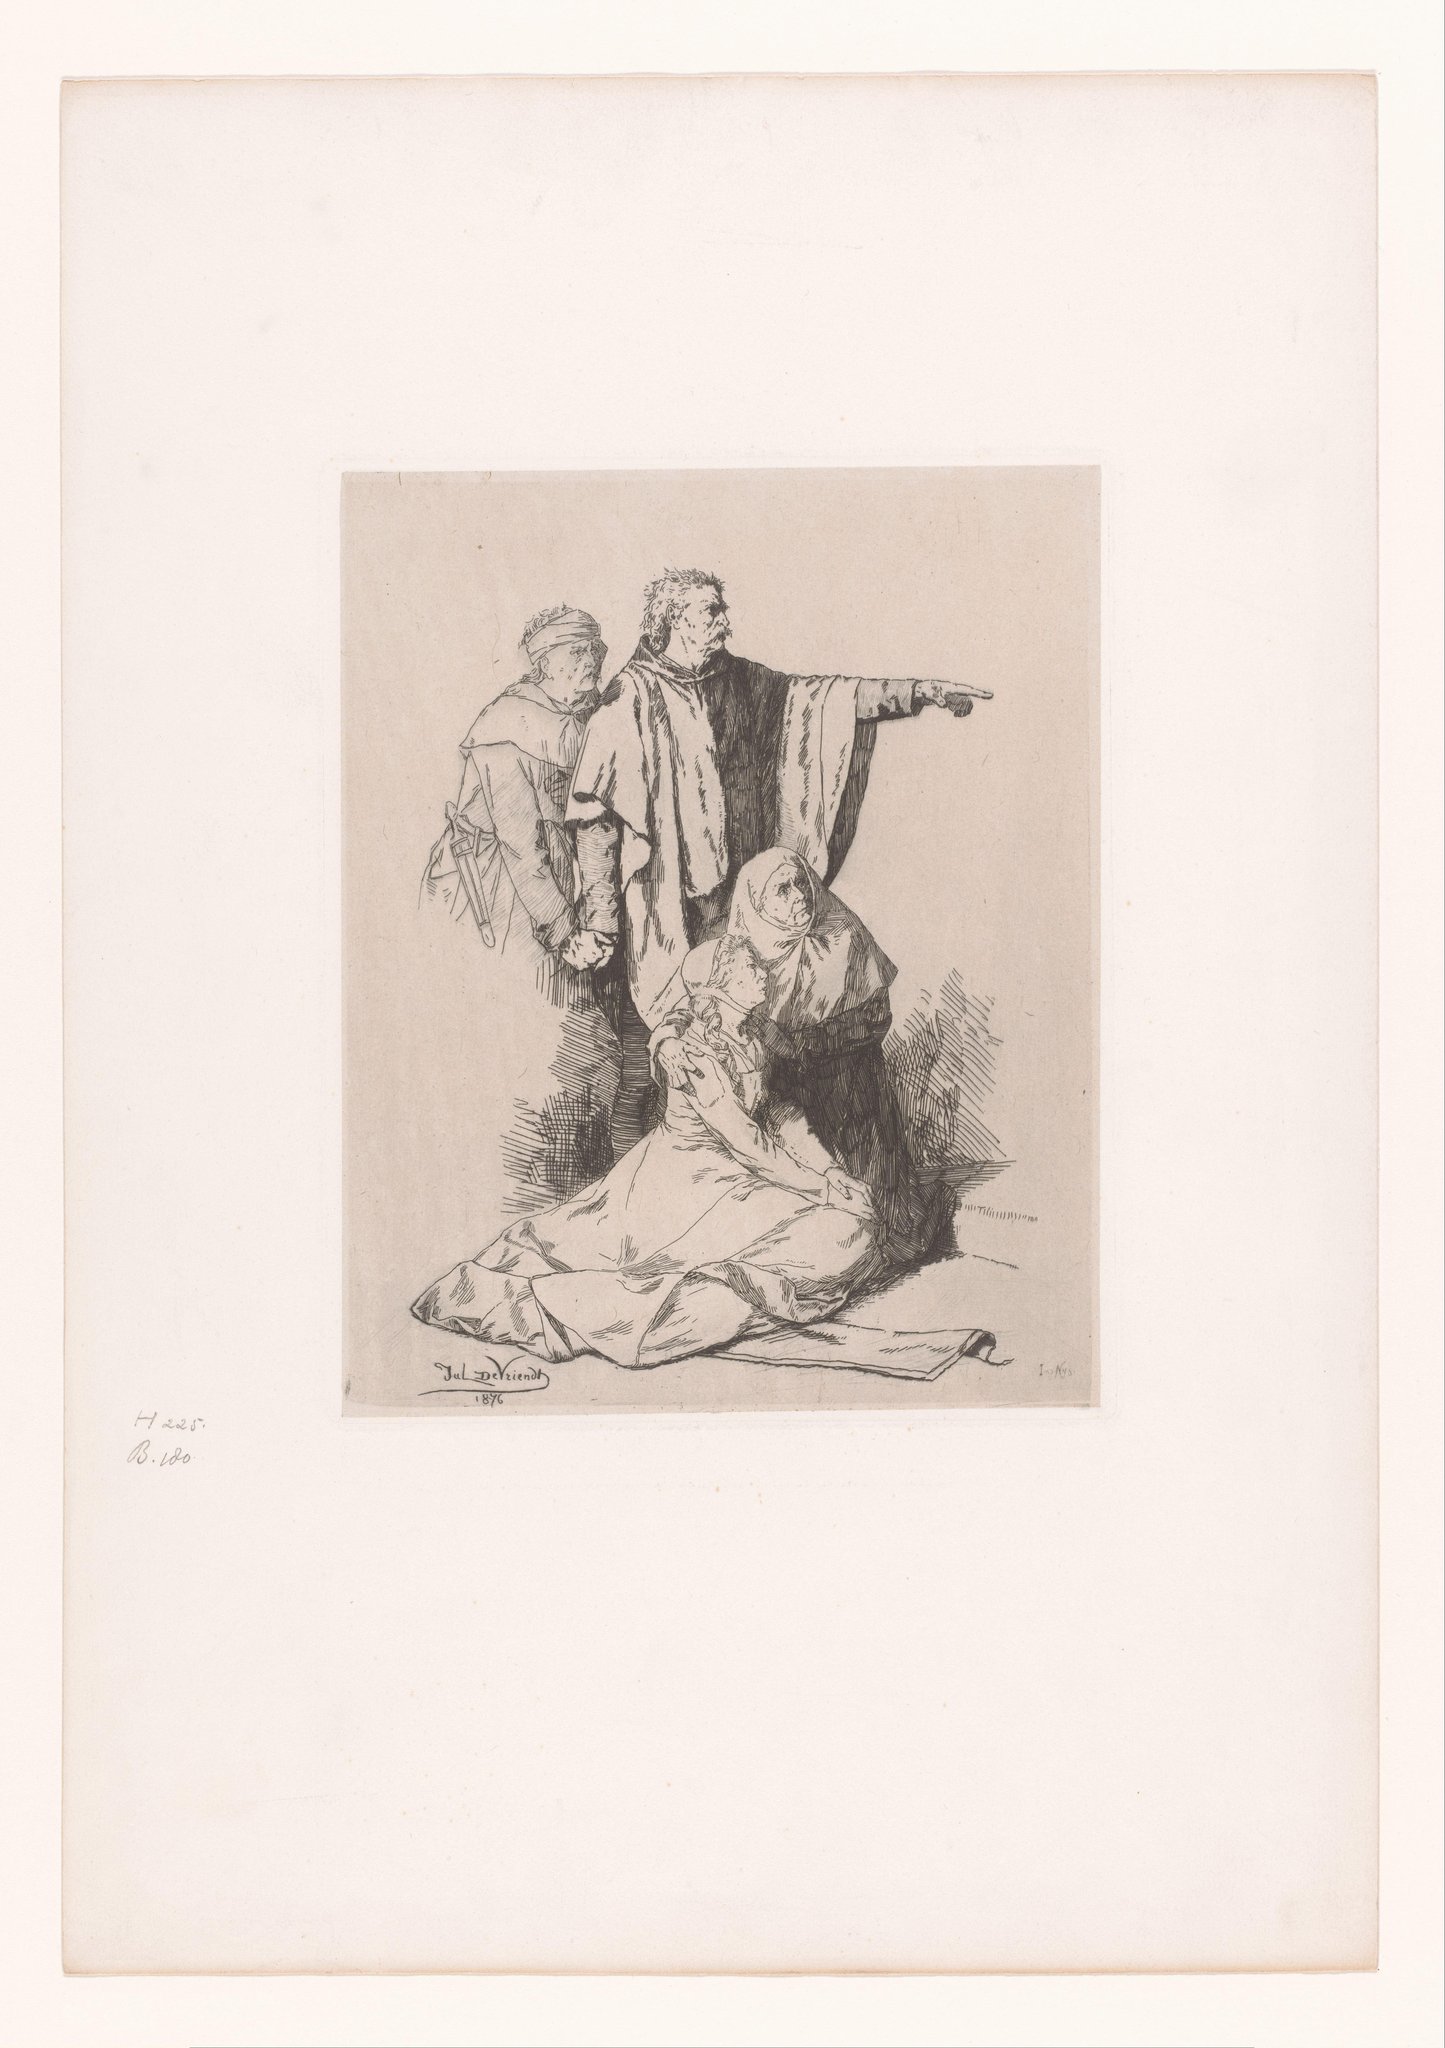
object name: print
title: Twee mannen waarvan één wijzend staande achter twee vrouwen gezeten op de grond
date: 1876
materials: paper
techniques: etching, retroussage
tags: the accused, adult man (+ two persons), adolescent, young woman, maiden, old woman, index finger forwards, pointing, indicating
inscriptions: collector's mark: Lugt 2228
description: Deze prent is verschenen in: Album du journal des Beaux-Arts, dix eaux-fortes inédites. Brussel, Parijs en Leipzig: S.n., 1876. Op voorblad van de publicatie getiteld: Justice de Baudouin à la Hache. De scène is een detail uit een schilderij van Juliaan de Vriendt waarop Boudewijn VII van Vlaanderen een edelman veroordeelt.